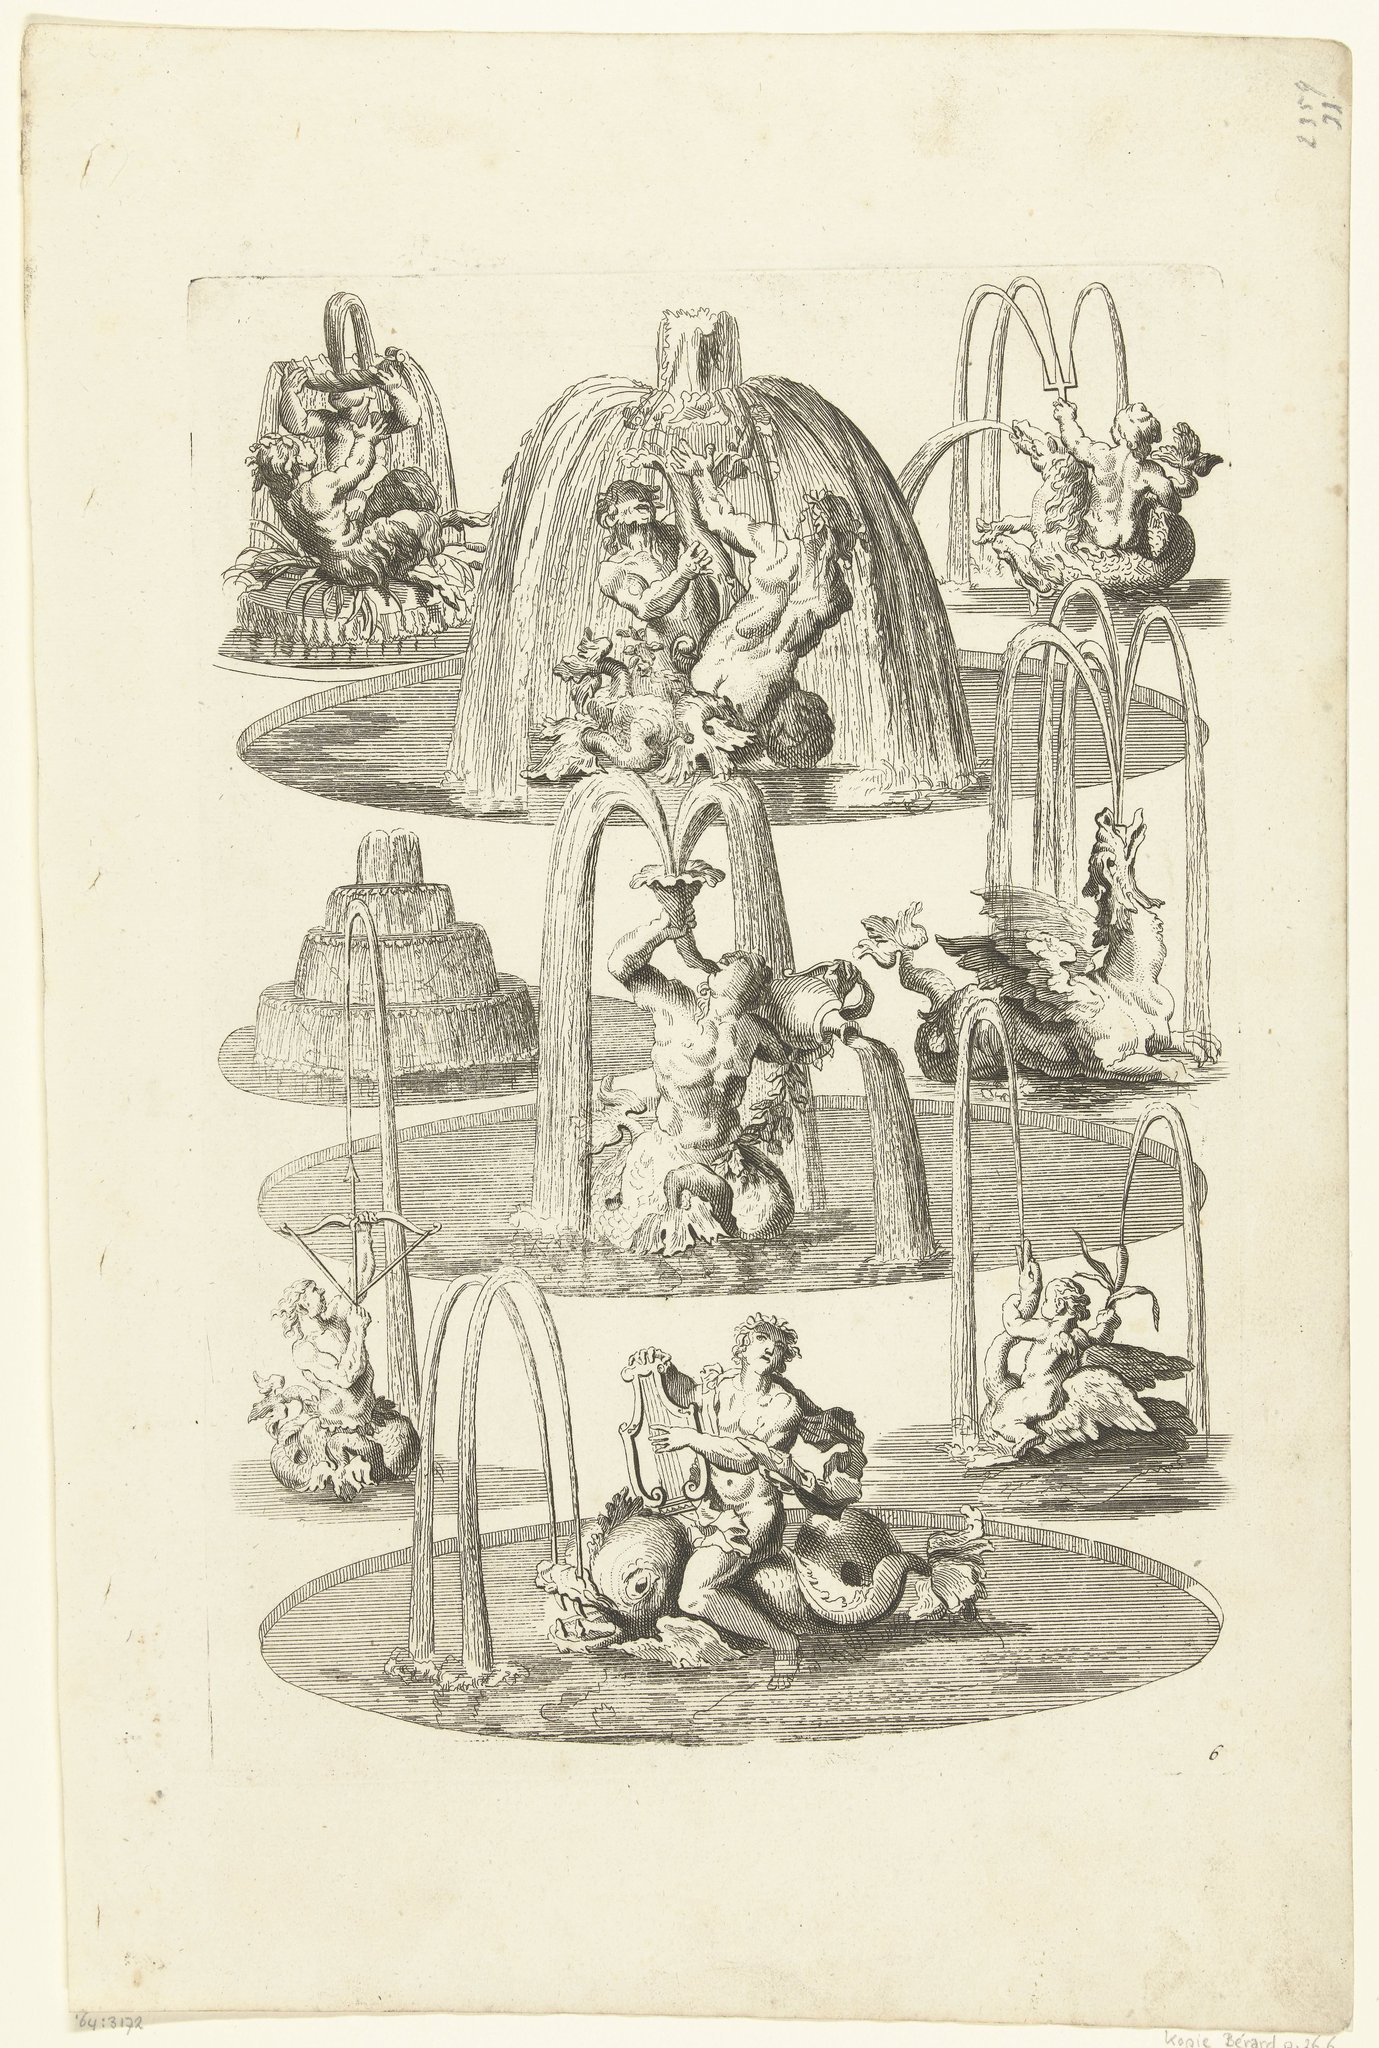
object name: print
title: Nova Fontium Delineatio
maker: Anonymous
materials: paper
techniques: etching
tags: swimming mammals: dolphin, (story of) apollo (phoebus), garden fountain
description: Onderaan Apollo op een dolfijn. Kopie naar blad uit serie Liure de fontaines uitgegeven door Daniel Marot.